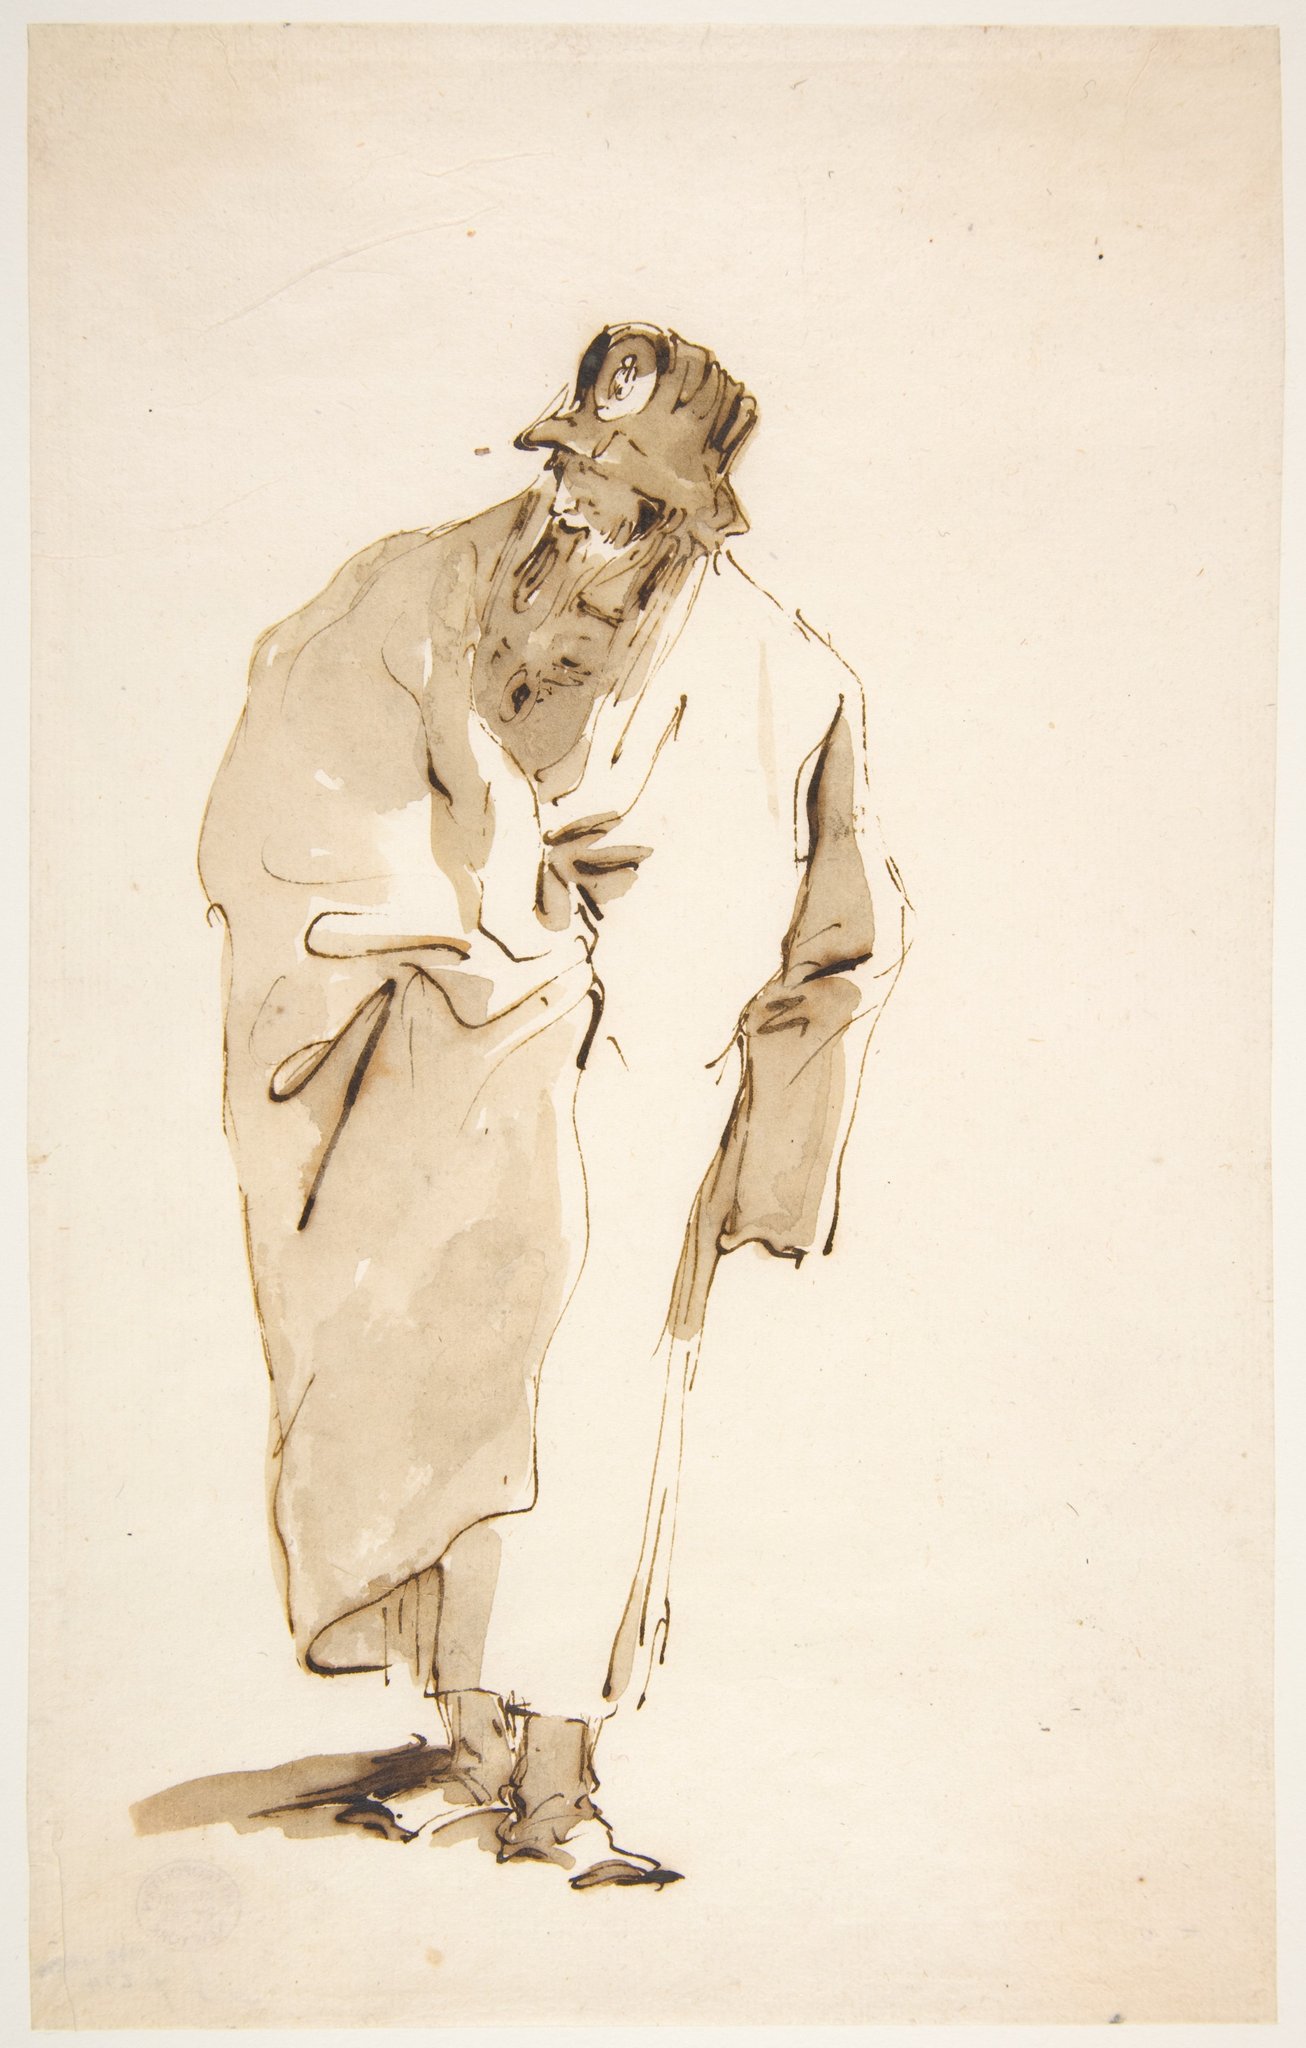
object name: drawing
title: Standing Man in a Full Coat and High Hat with a Medaillon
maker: giovanni battista tiepolo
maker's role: artist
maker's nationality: italian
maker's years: 1696-1770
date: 1696-1770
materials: ink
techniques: brush, pen, wash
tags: men